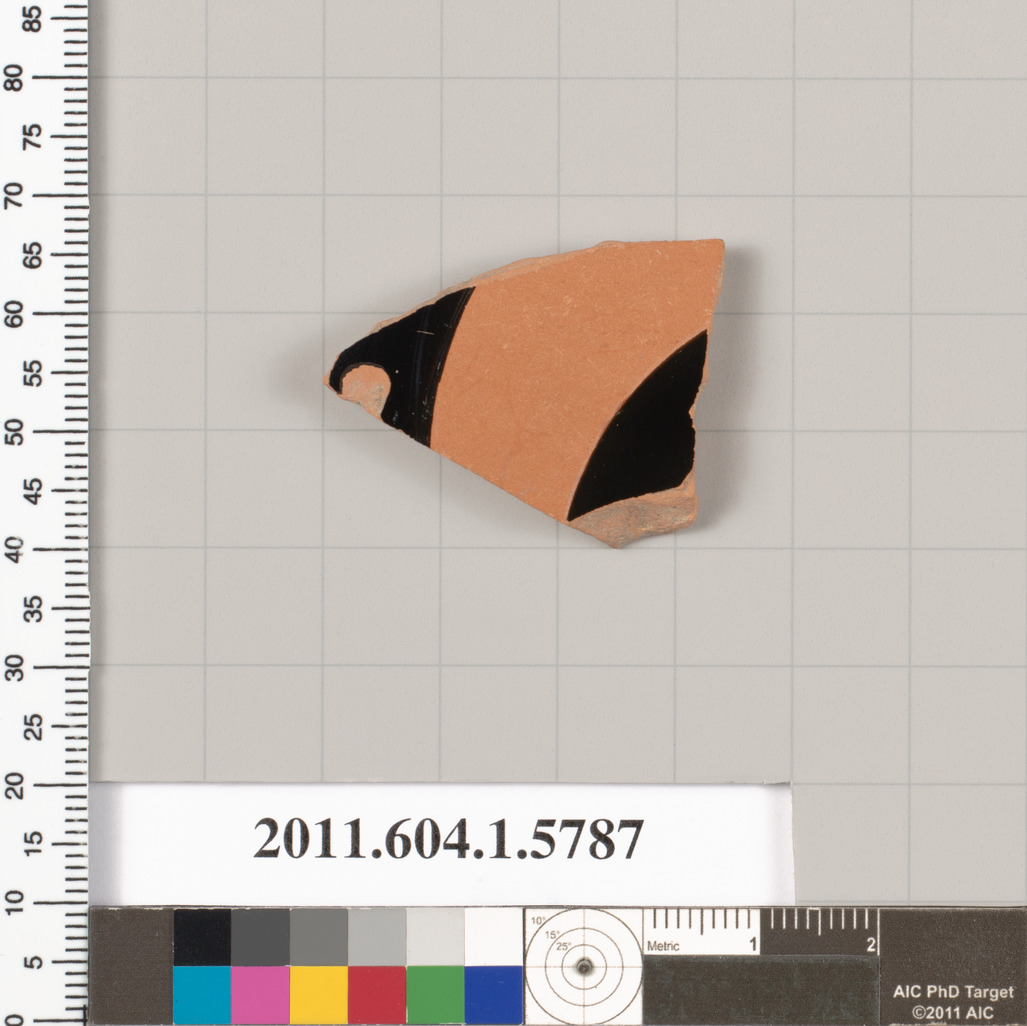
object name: kylix fragment, eye cup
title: Terracotta fragment of a kylix: eye-cup (drinking cup)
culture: greek, attic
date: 520-510 BCE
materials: terracotta